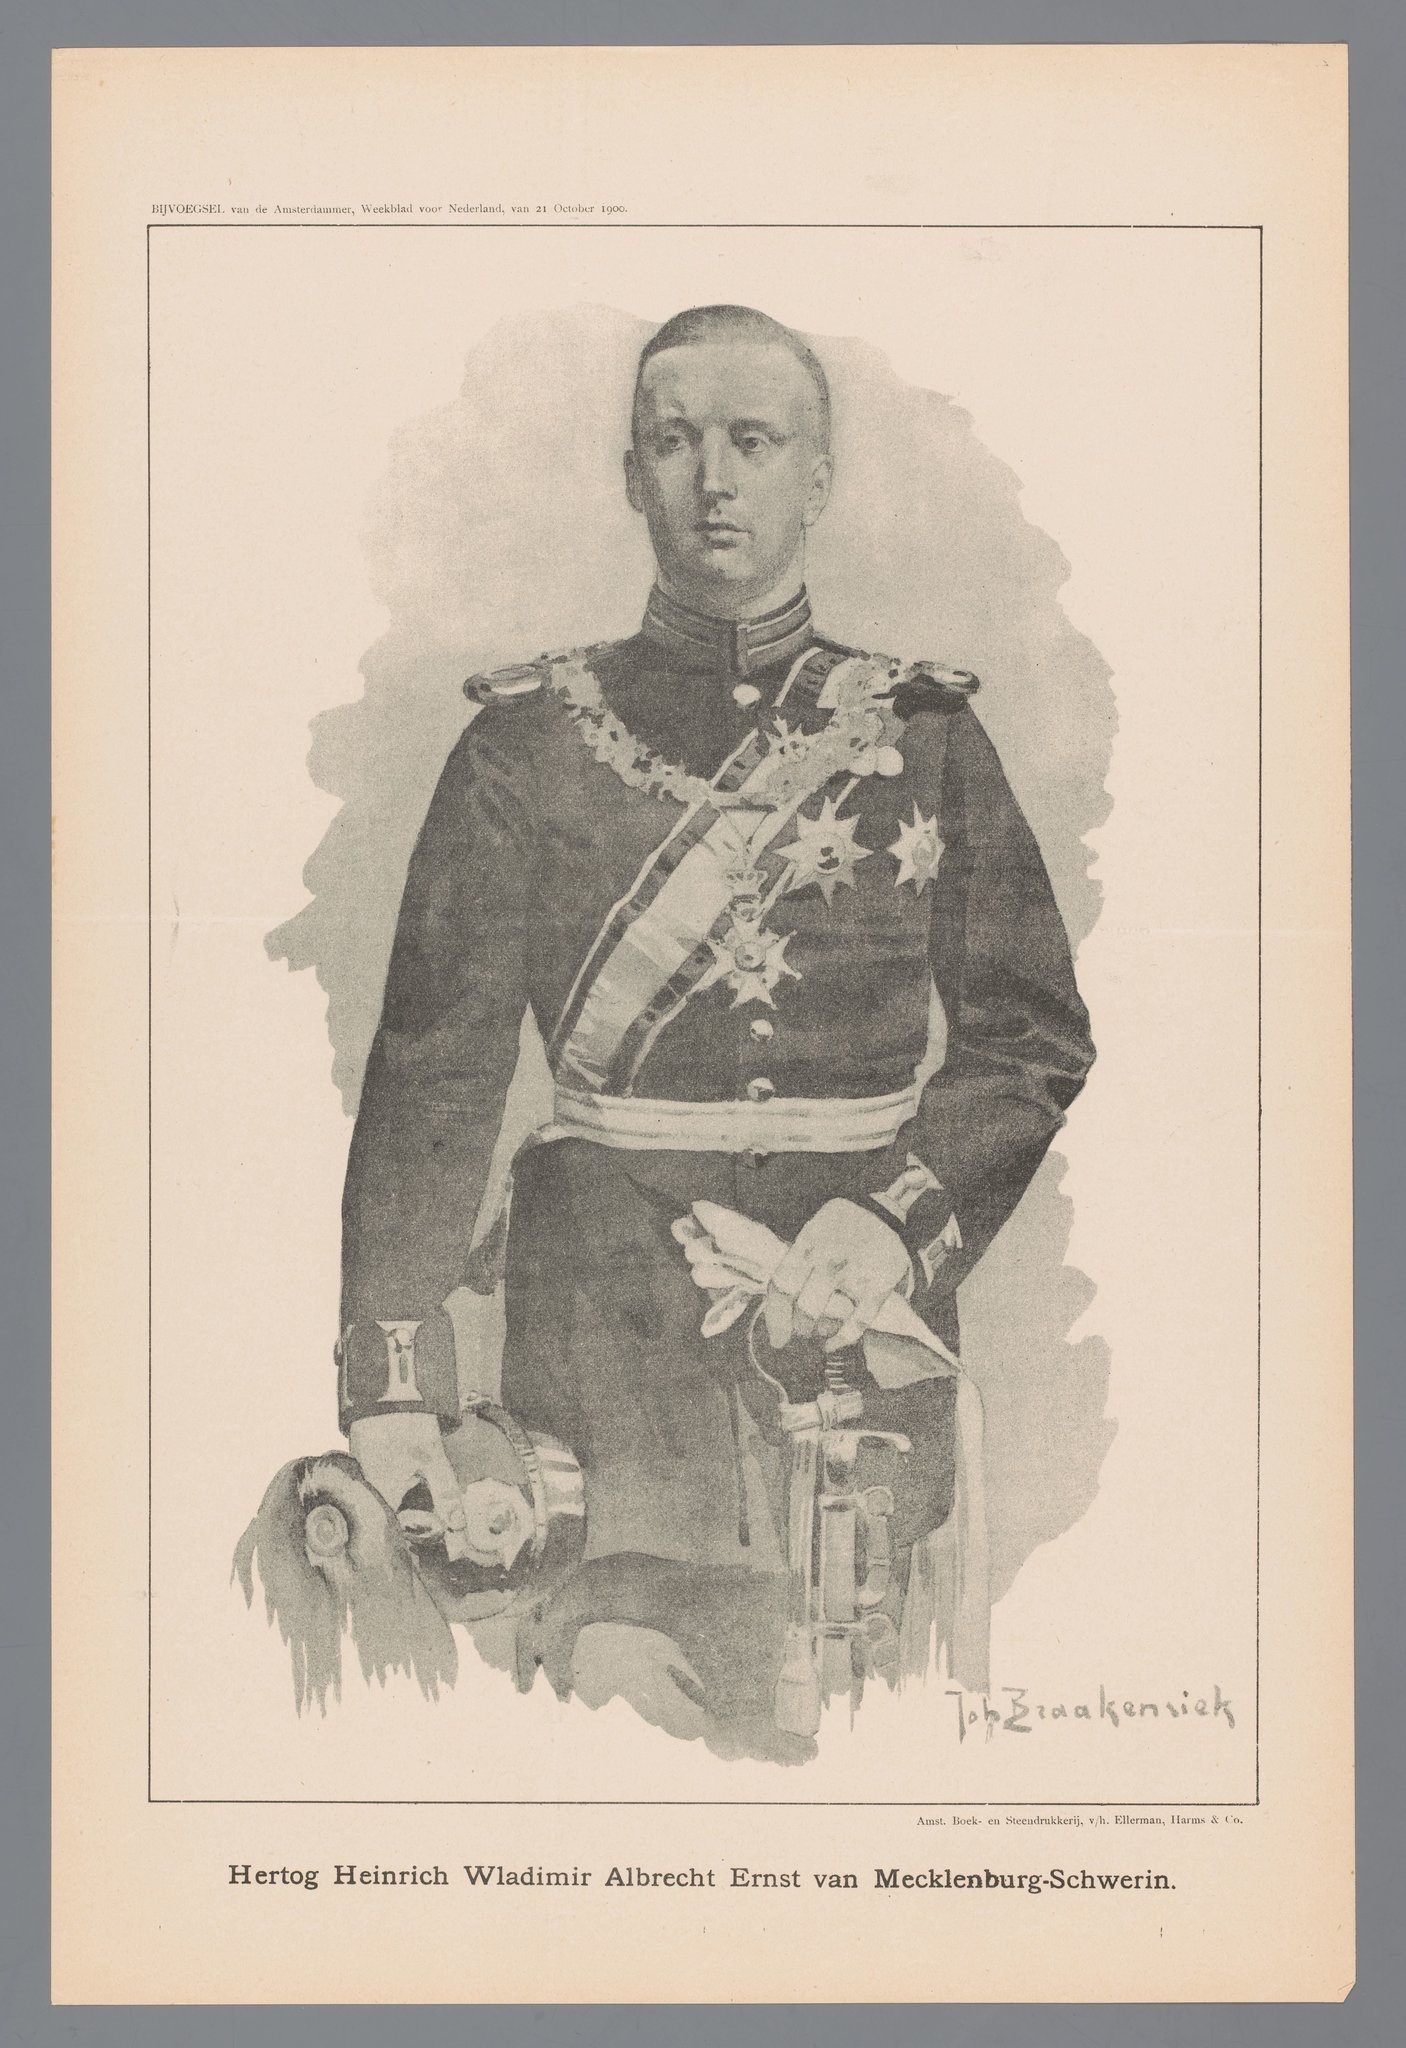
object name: print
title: Hertog Heinrich Wladimir Albrecht Ernst van Mecklenburg-Schwerin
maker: johan braakensiek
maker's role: draughtsman, print maker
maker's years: 1858-1940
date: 1900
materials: paper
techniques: lithograph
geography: amsterdam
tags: the hague, hendrik (prins der nederlanden (1876-1934)), historical persons, ruler, sovereign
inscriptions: date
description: Prent uit het bijvoegsel van: De Amsterdammer. Weekblad voor Nederland, 21 oktober 1900.